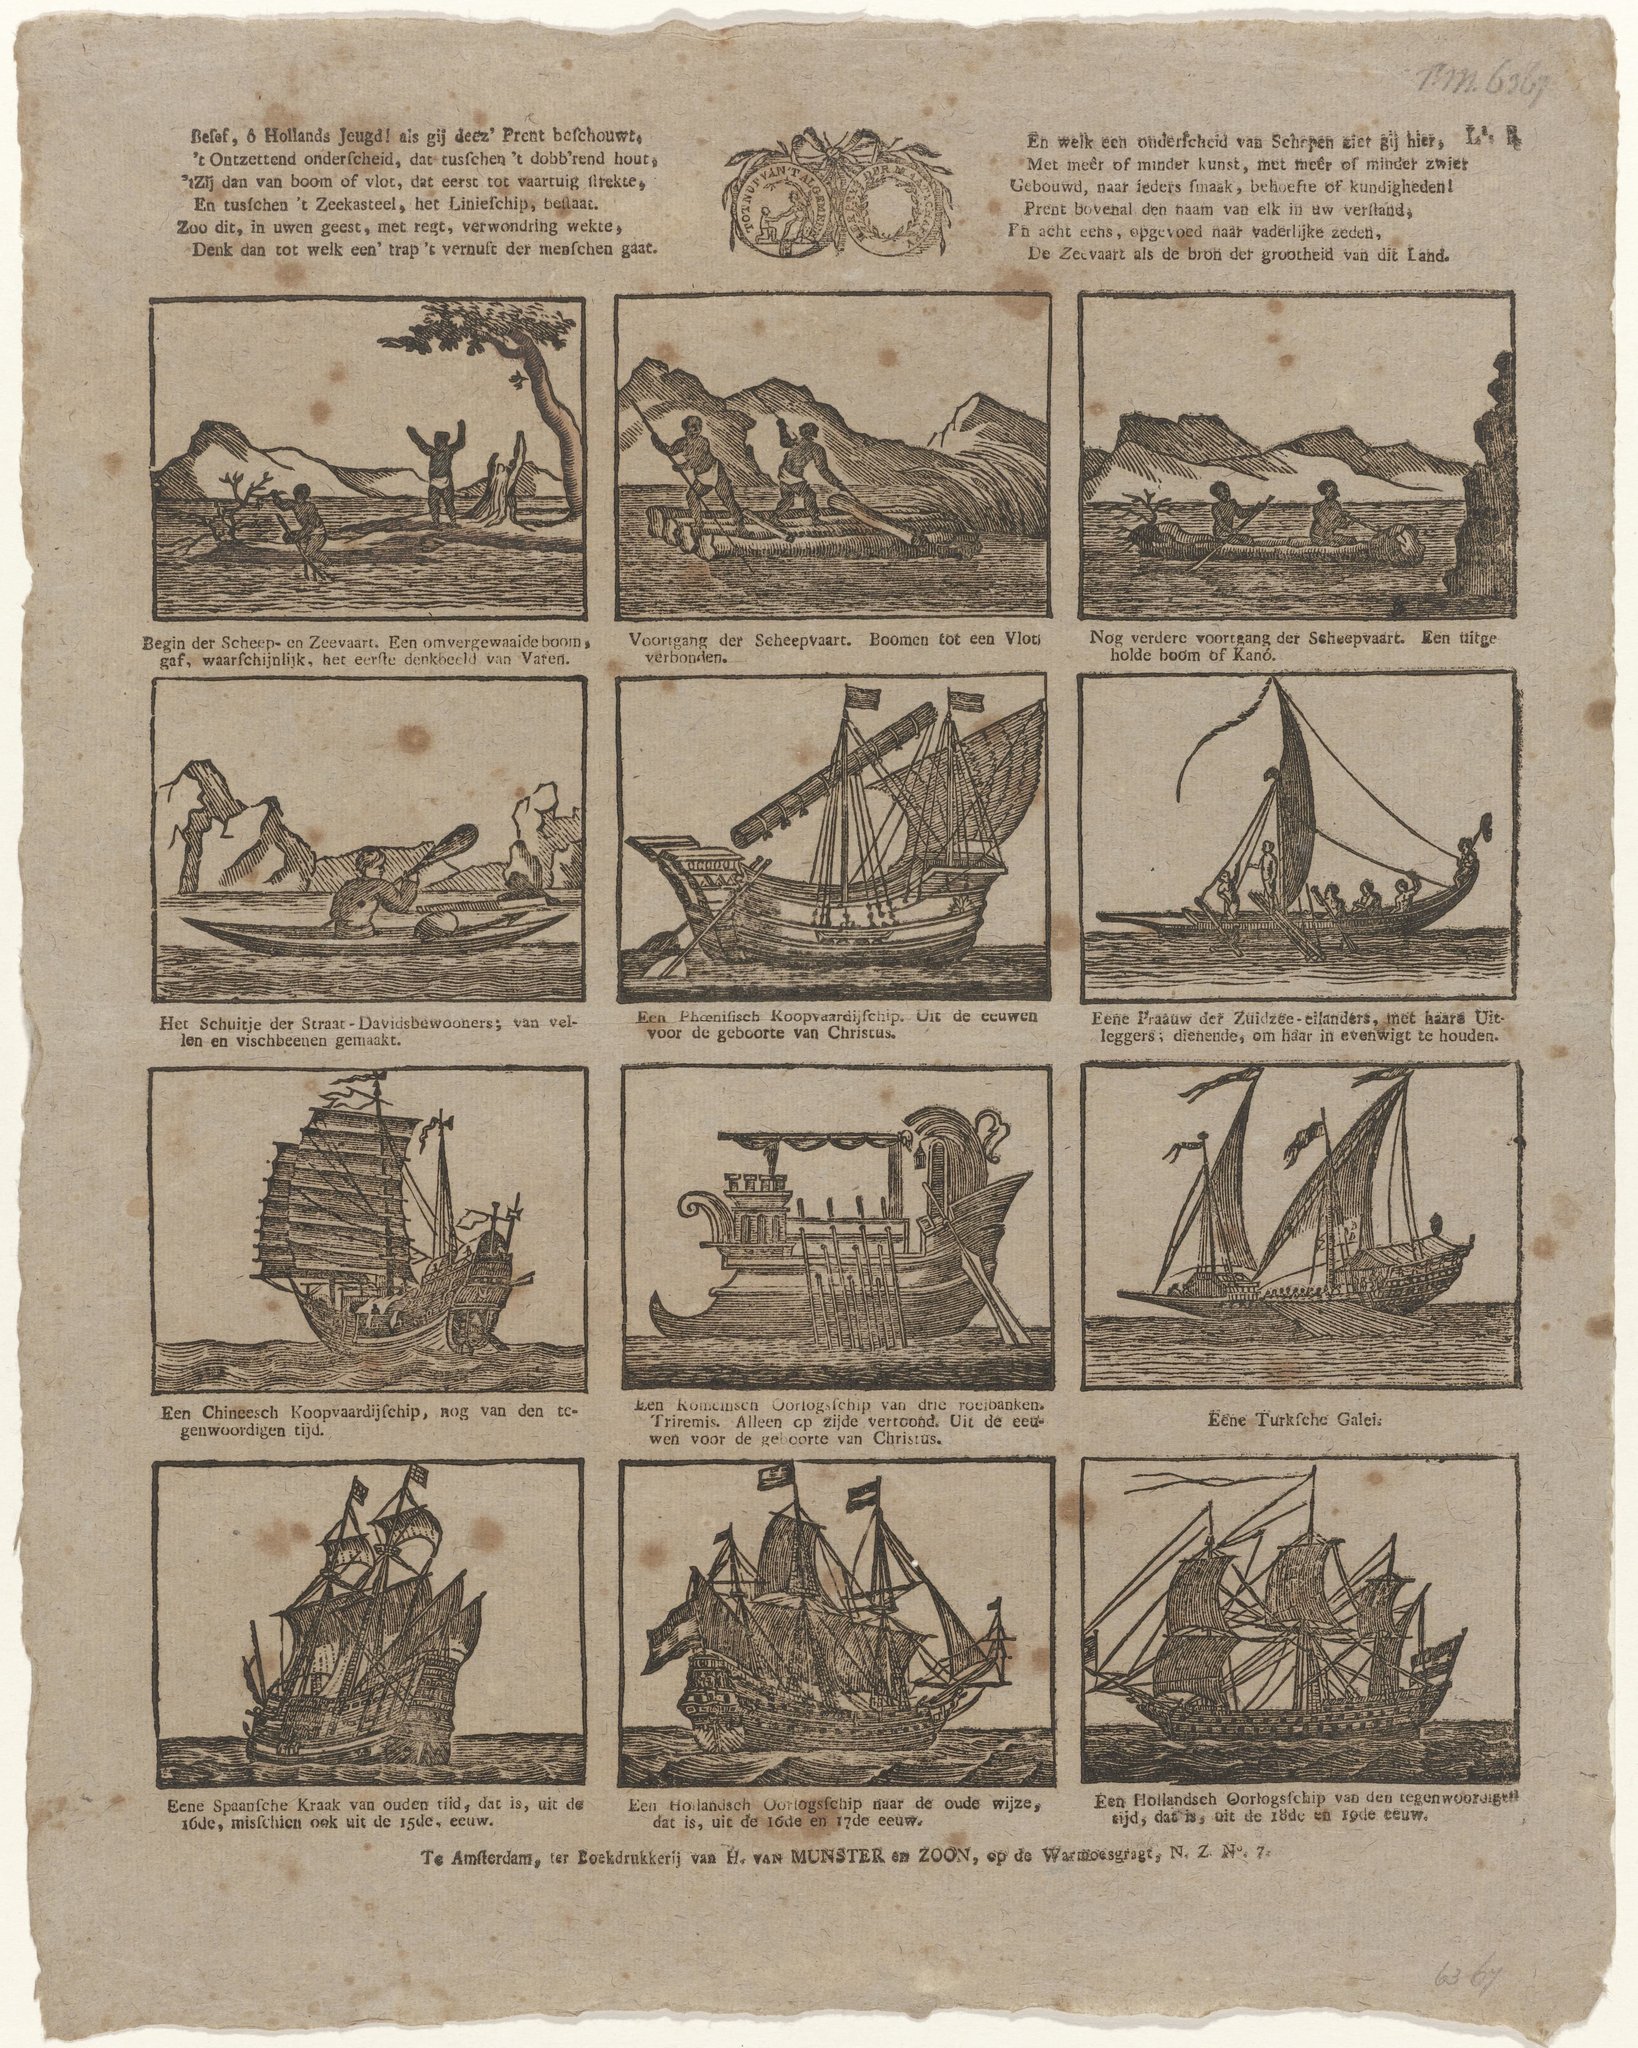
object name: print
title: Besef, o Hollands Jeugd! als gij deez' Prent beschouwt, / 't Ontzettend onderscheid, dat tusschen 't dobb'rend hout (...)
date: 1840-1899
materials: paper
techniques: letterpress printing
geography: amsterdam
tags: traffic on the water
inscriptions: collector's mark: Lugt 2228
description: Blad met twaalf voorstellingen van de ontwikkeling van het vaartuig, van primitieve boomstam tot tegenwoordig Hollands oorlogsschip. Onder elk plaatje een onderschrift van twee of drie regels. Voorzien van het zegel van de Maatschappij Tot Nut van 't Algemeen. Genummerd rechtsboven: La. R. Ca. 1840-1900.